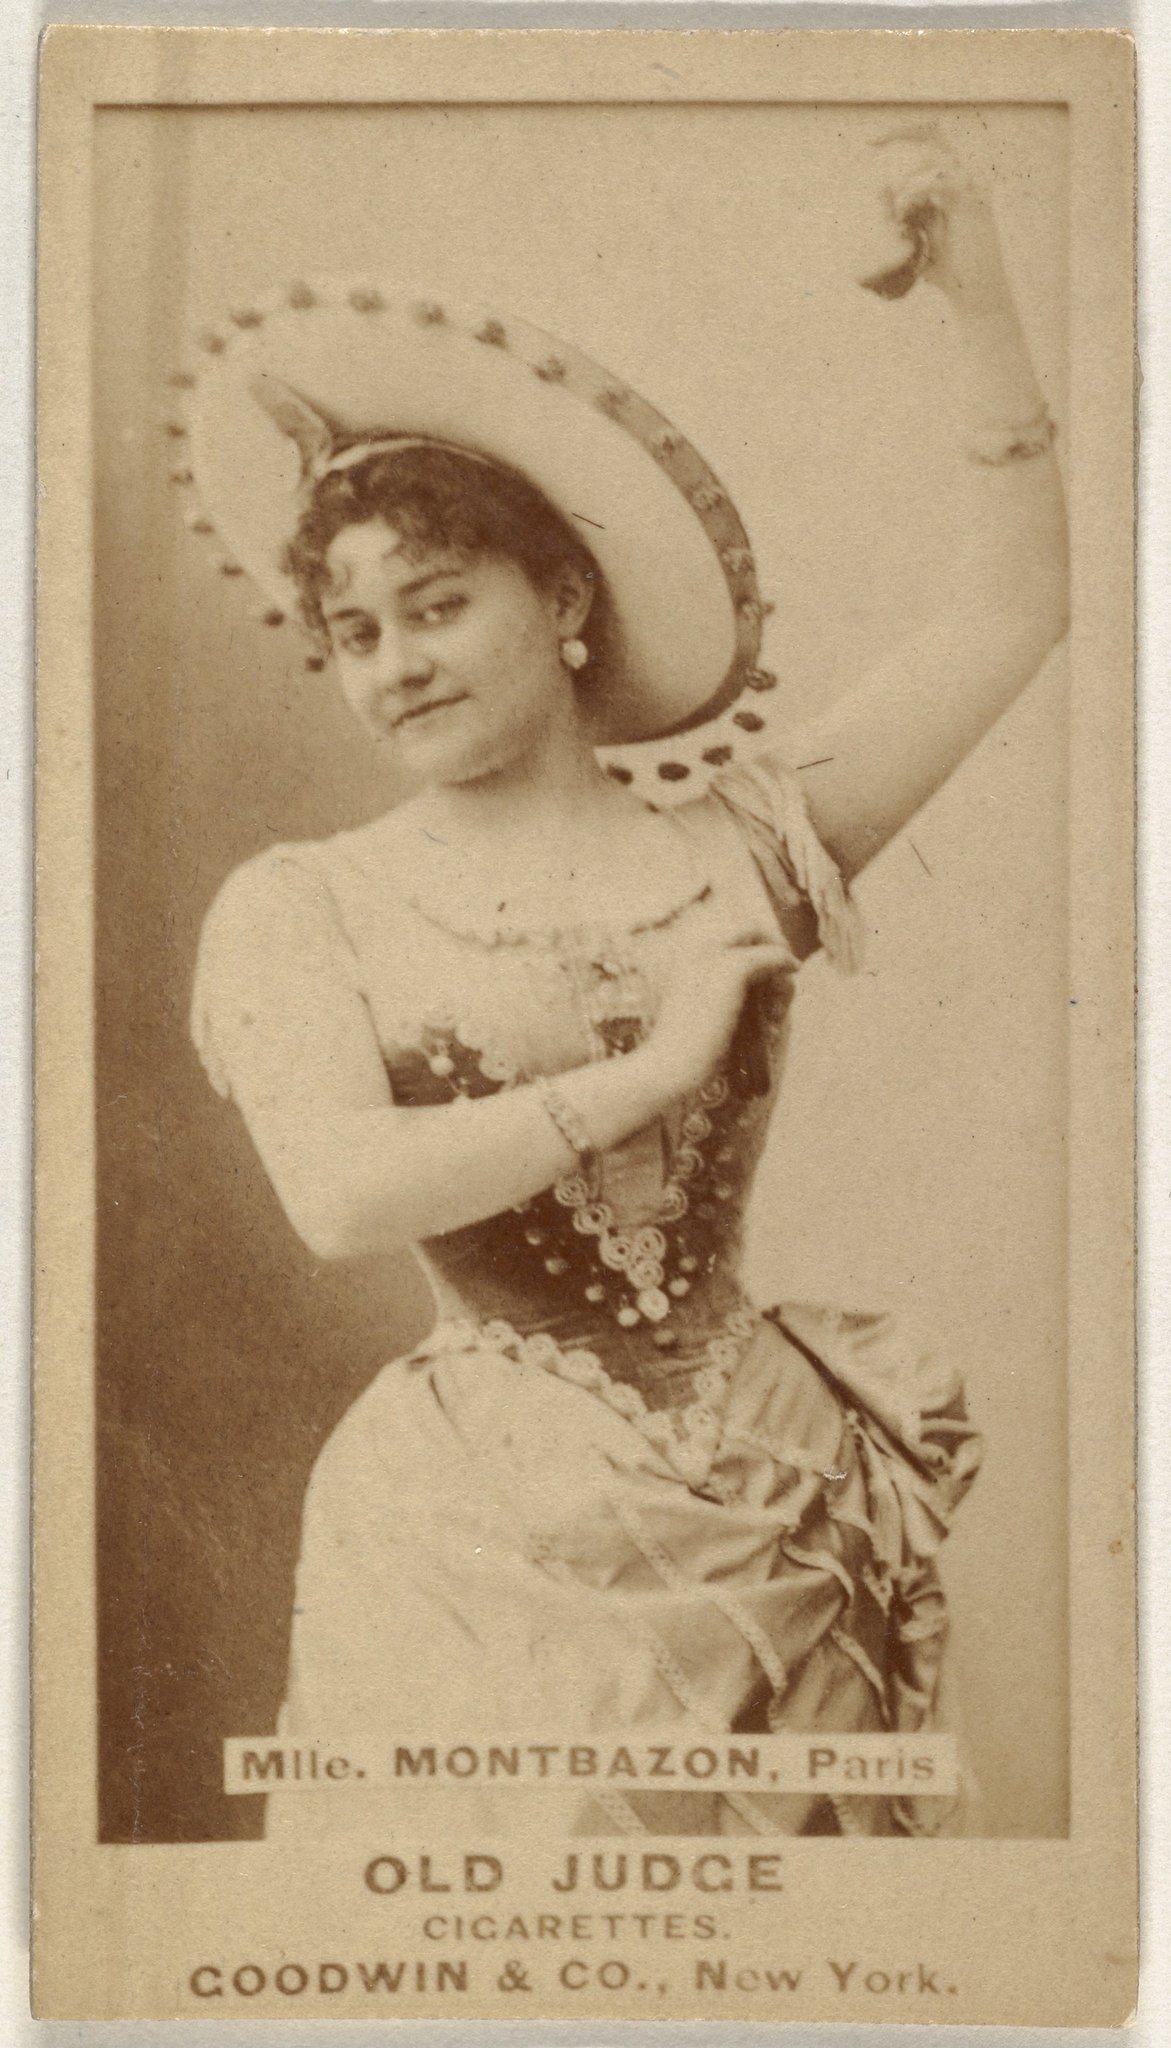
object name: photograph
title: Mlle. Montbazon, Paris, from the Actors and Actresses series (N171) for Old Judge Cigarettes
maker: goodwin & company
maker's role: publisher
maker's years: 1850-1950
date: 1886-1890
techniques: albumen silver print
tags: portraits,women,actresses